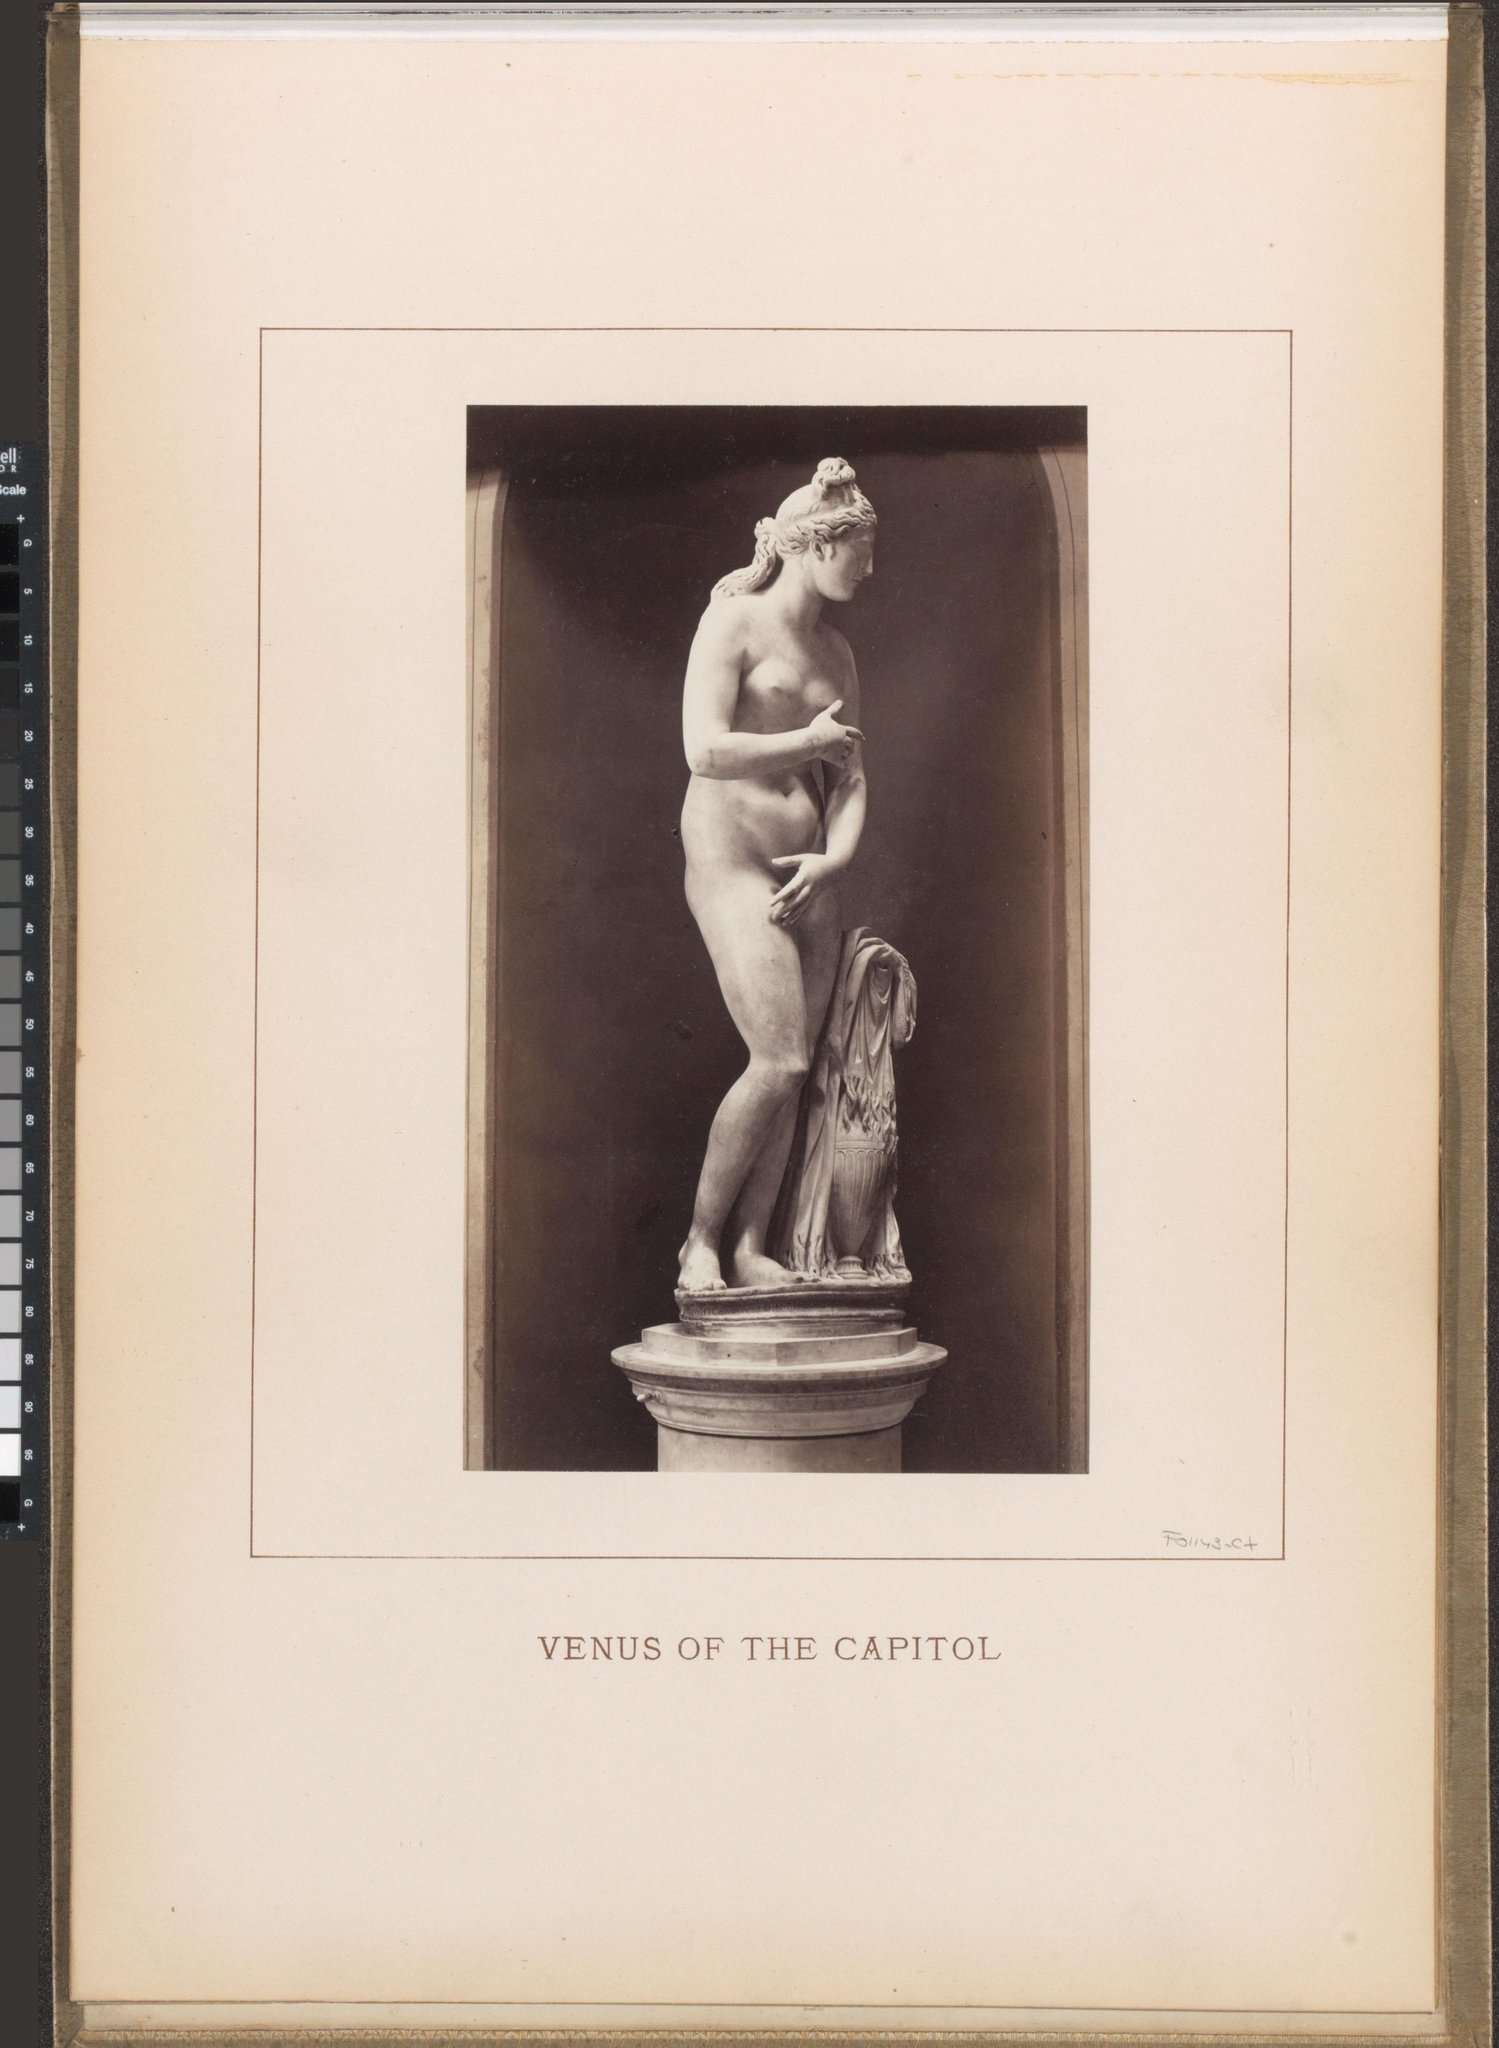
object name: photograph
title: Venus of the Capitol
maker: Anonymous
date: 1860-1900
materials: photographic support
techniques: albumen print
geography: capitolijnse musea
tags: piece of sculpture, reproduction of a piece of sculpture, (story of) venus (aphrodite)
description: Onderdeel van Fotoalbum met opnames van bezienswaardigheden en kunstwerken in Rome.